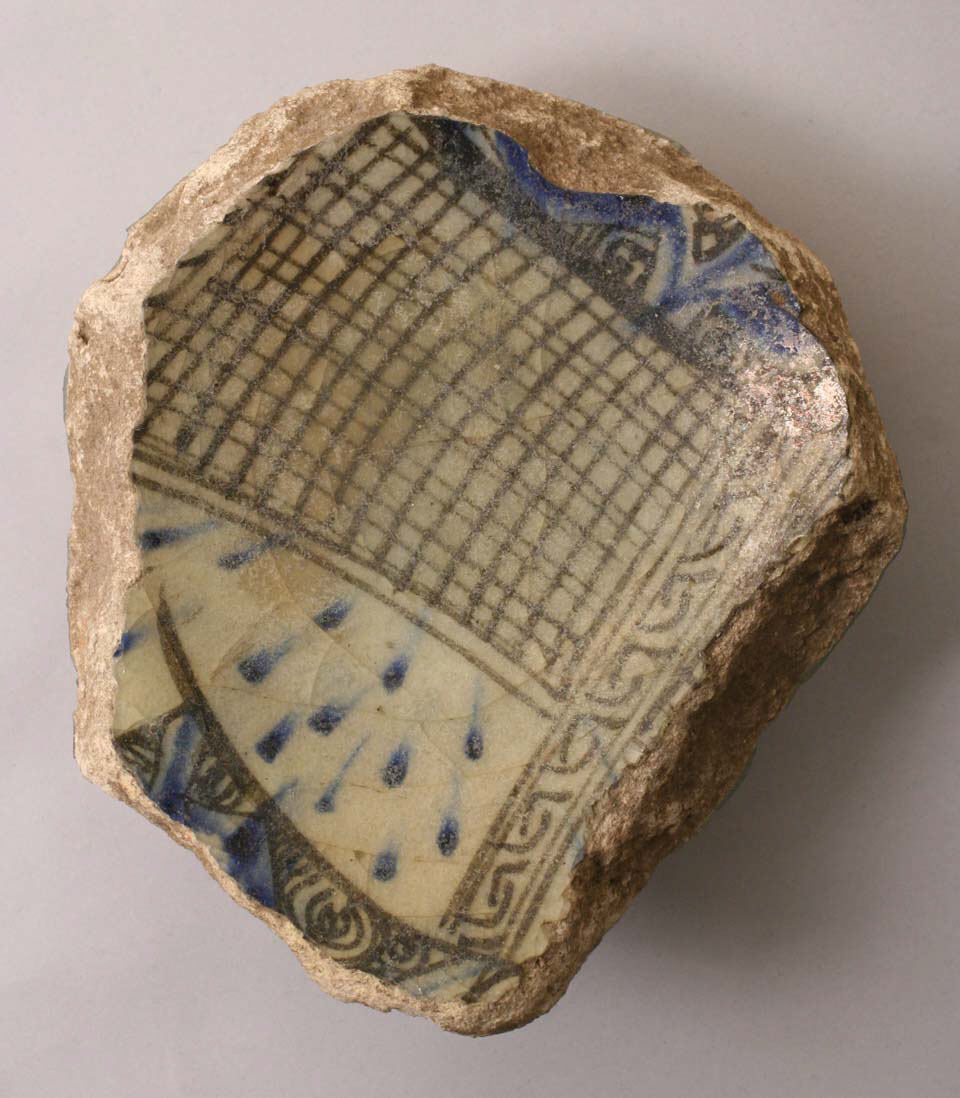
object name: ceramic fragment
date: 1301-1400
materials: glaze, stonepaste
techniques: painting, polychrome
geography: syria